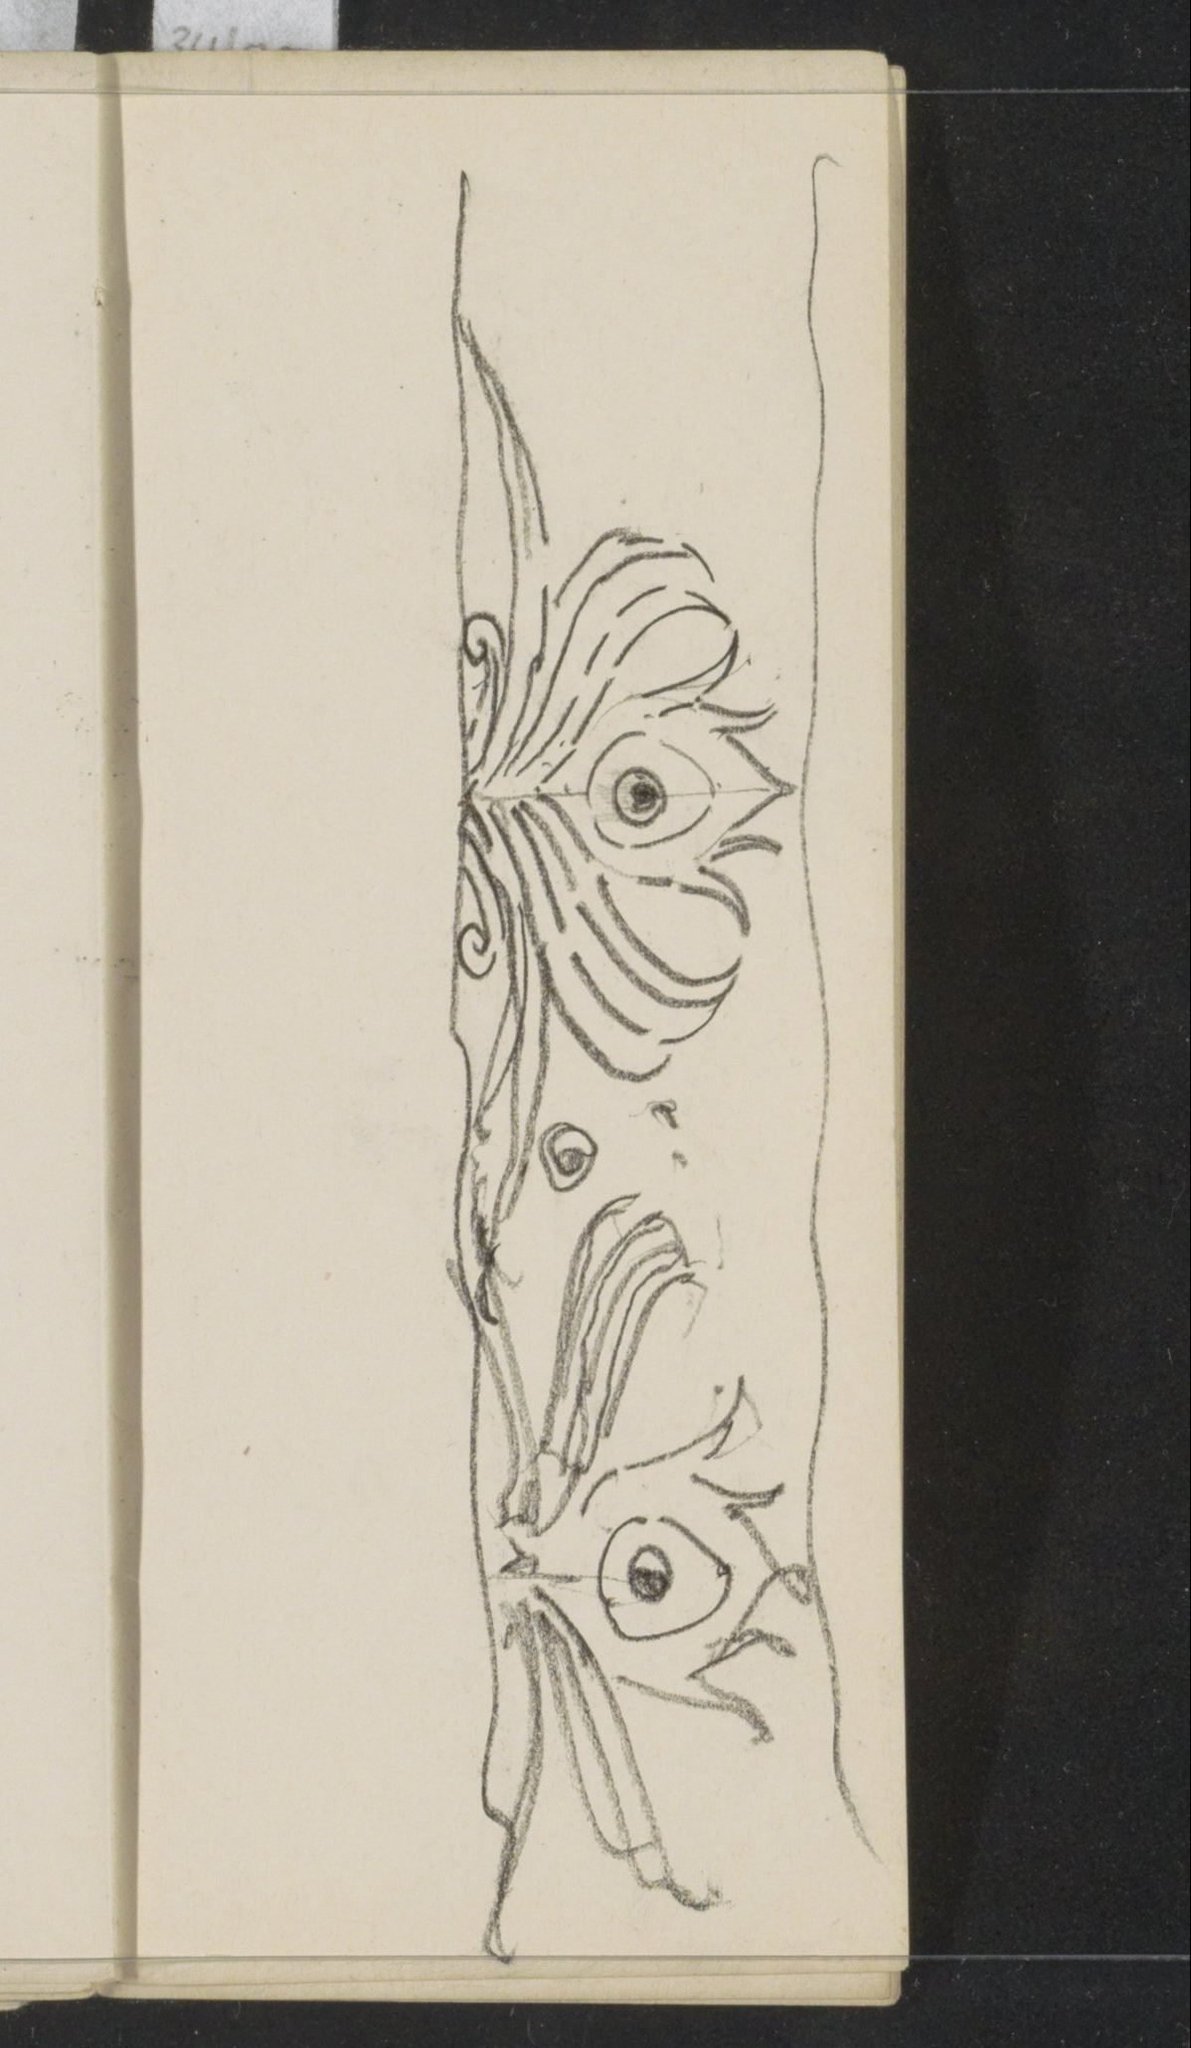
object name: sketchbook leaf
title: Band met een plantmotief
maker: gerrit willem dijsselhof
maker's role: designer, draughtsman, print maker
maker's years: 1866-1924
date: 1901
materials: chalk, paper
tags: foliage, tendrils, branches ~ ornament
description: Blad 27 recto uit een schetsboek met 42 bladzijden.